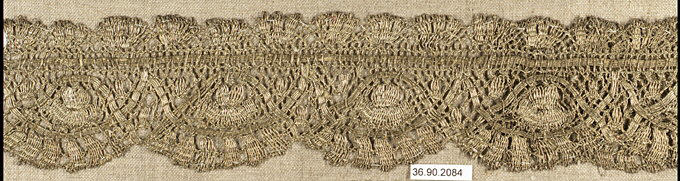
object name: piece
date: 1701-1800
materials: metal thread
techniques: lace